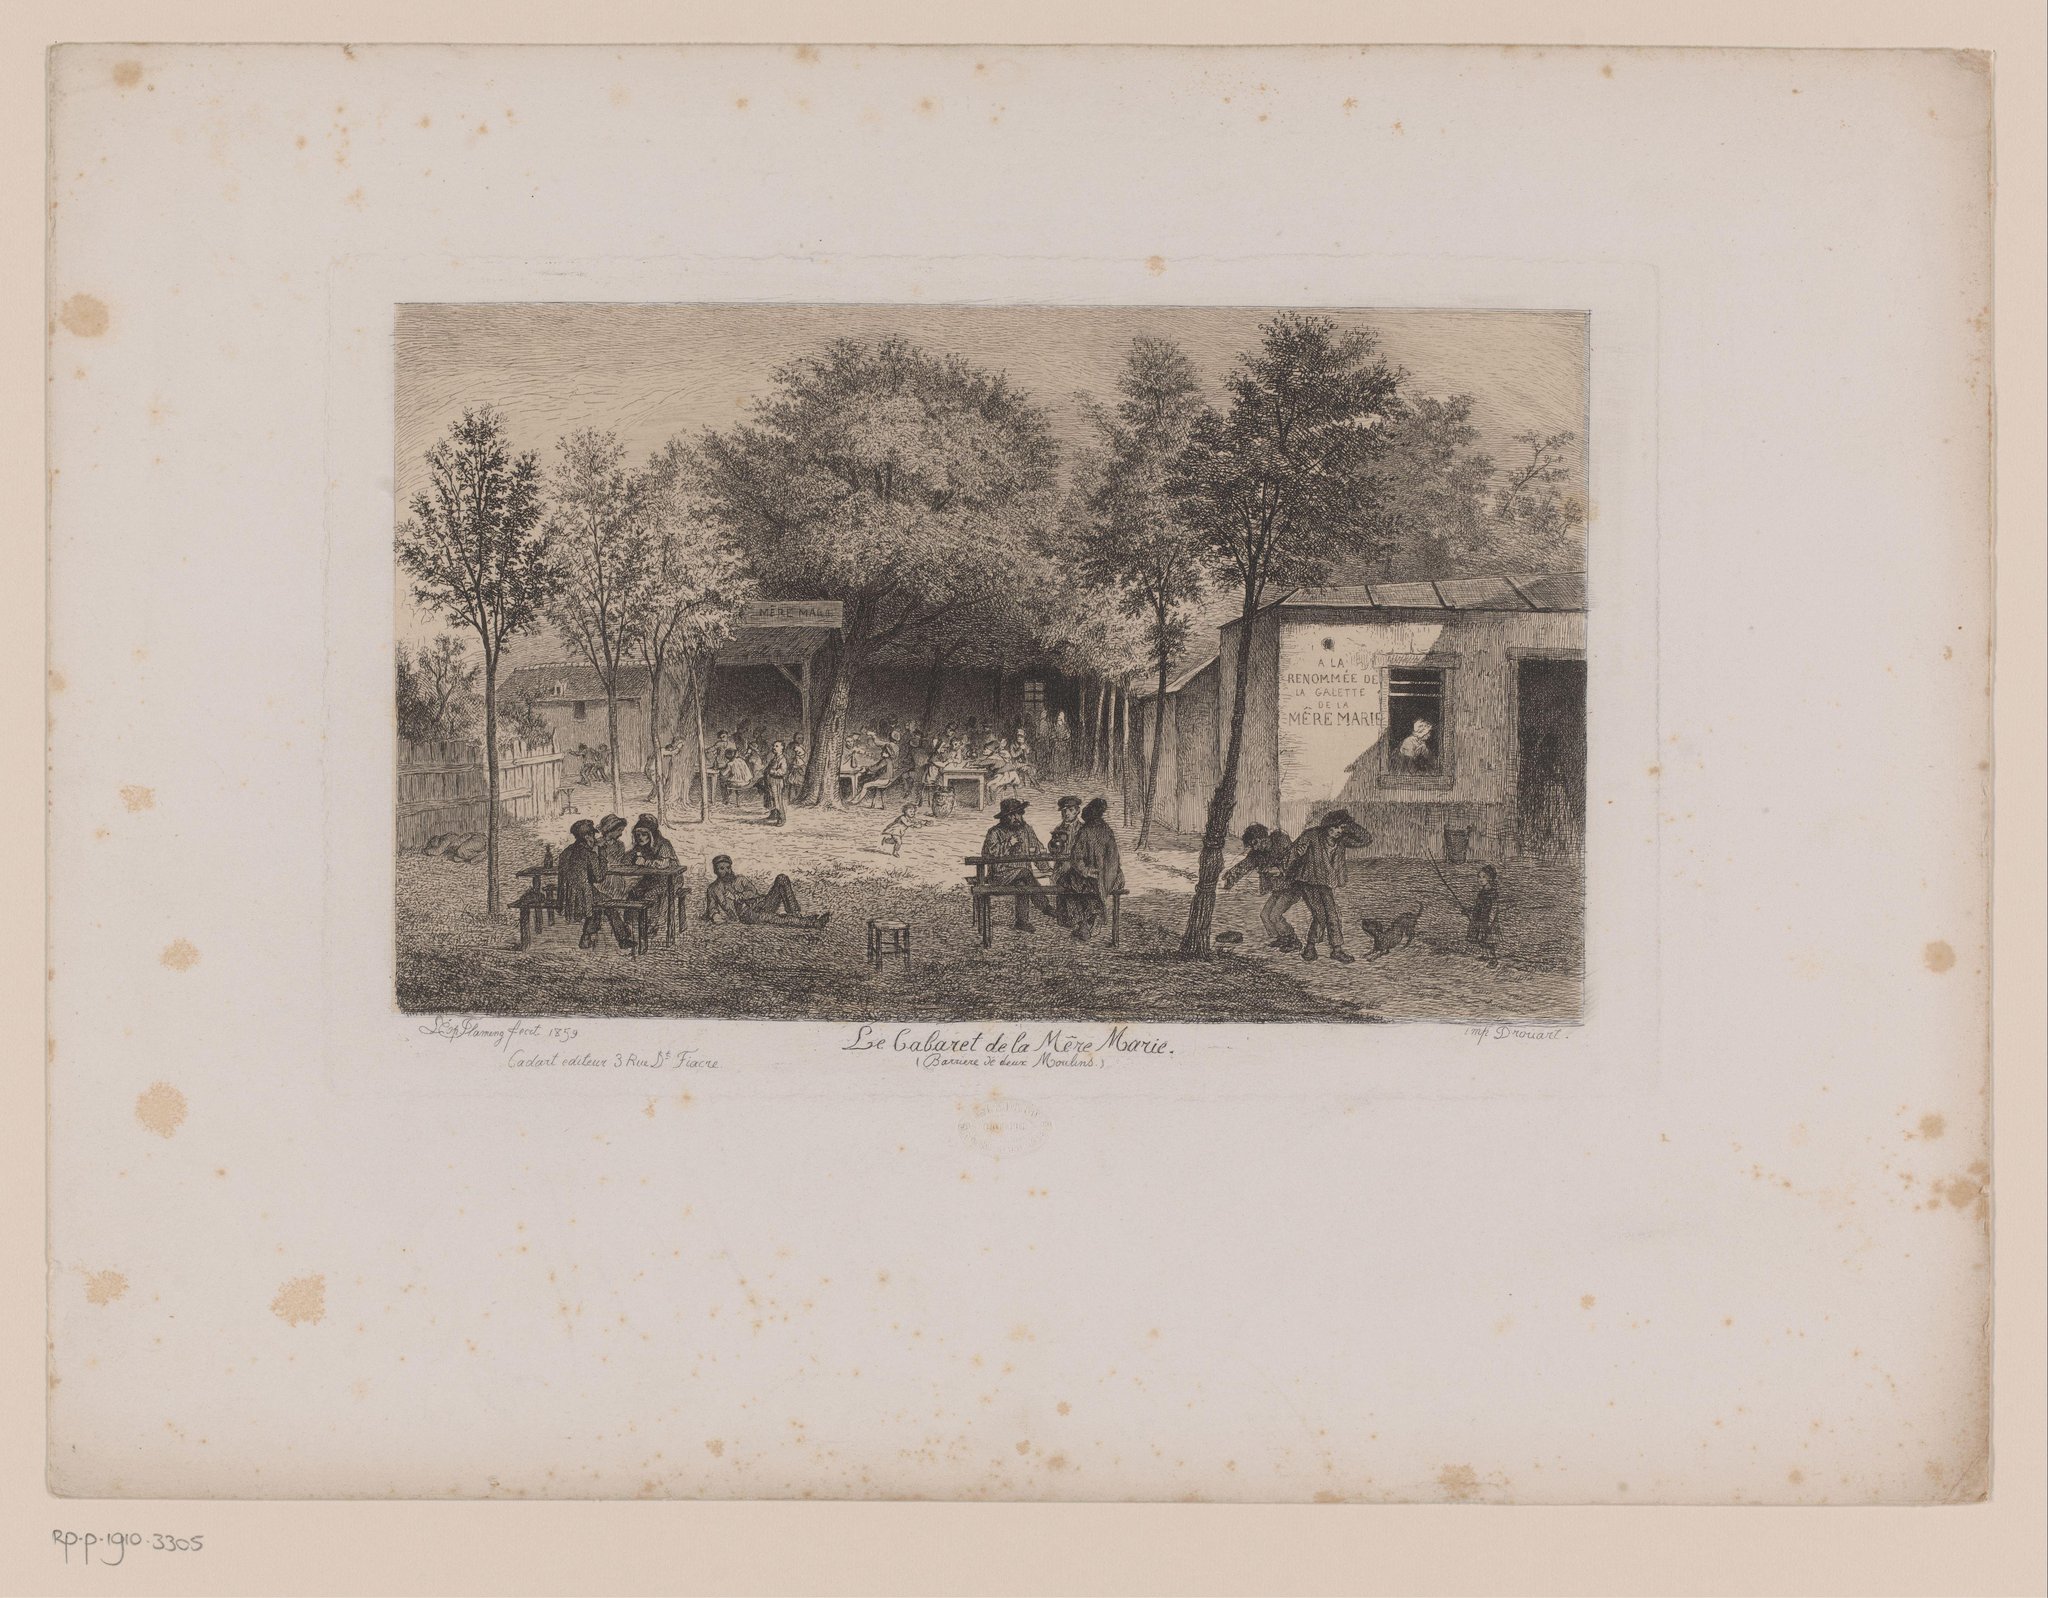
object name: print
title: Parijs komt en Parijs gaat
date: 1859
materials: paper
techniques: etching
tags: public gardens, park, paris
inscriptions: collector's mark: Lugt 2228, workshop stamp: ‘A. Cadart editeur 3 rue St. Fiacre Paris’